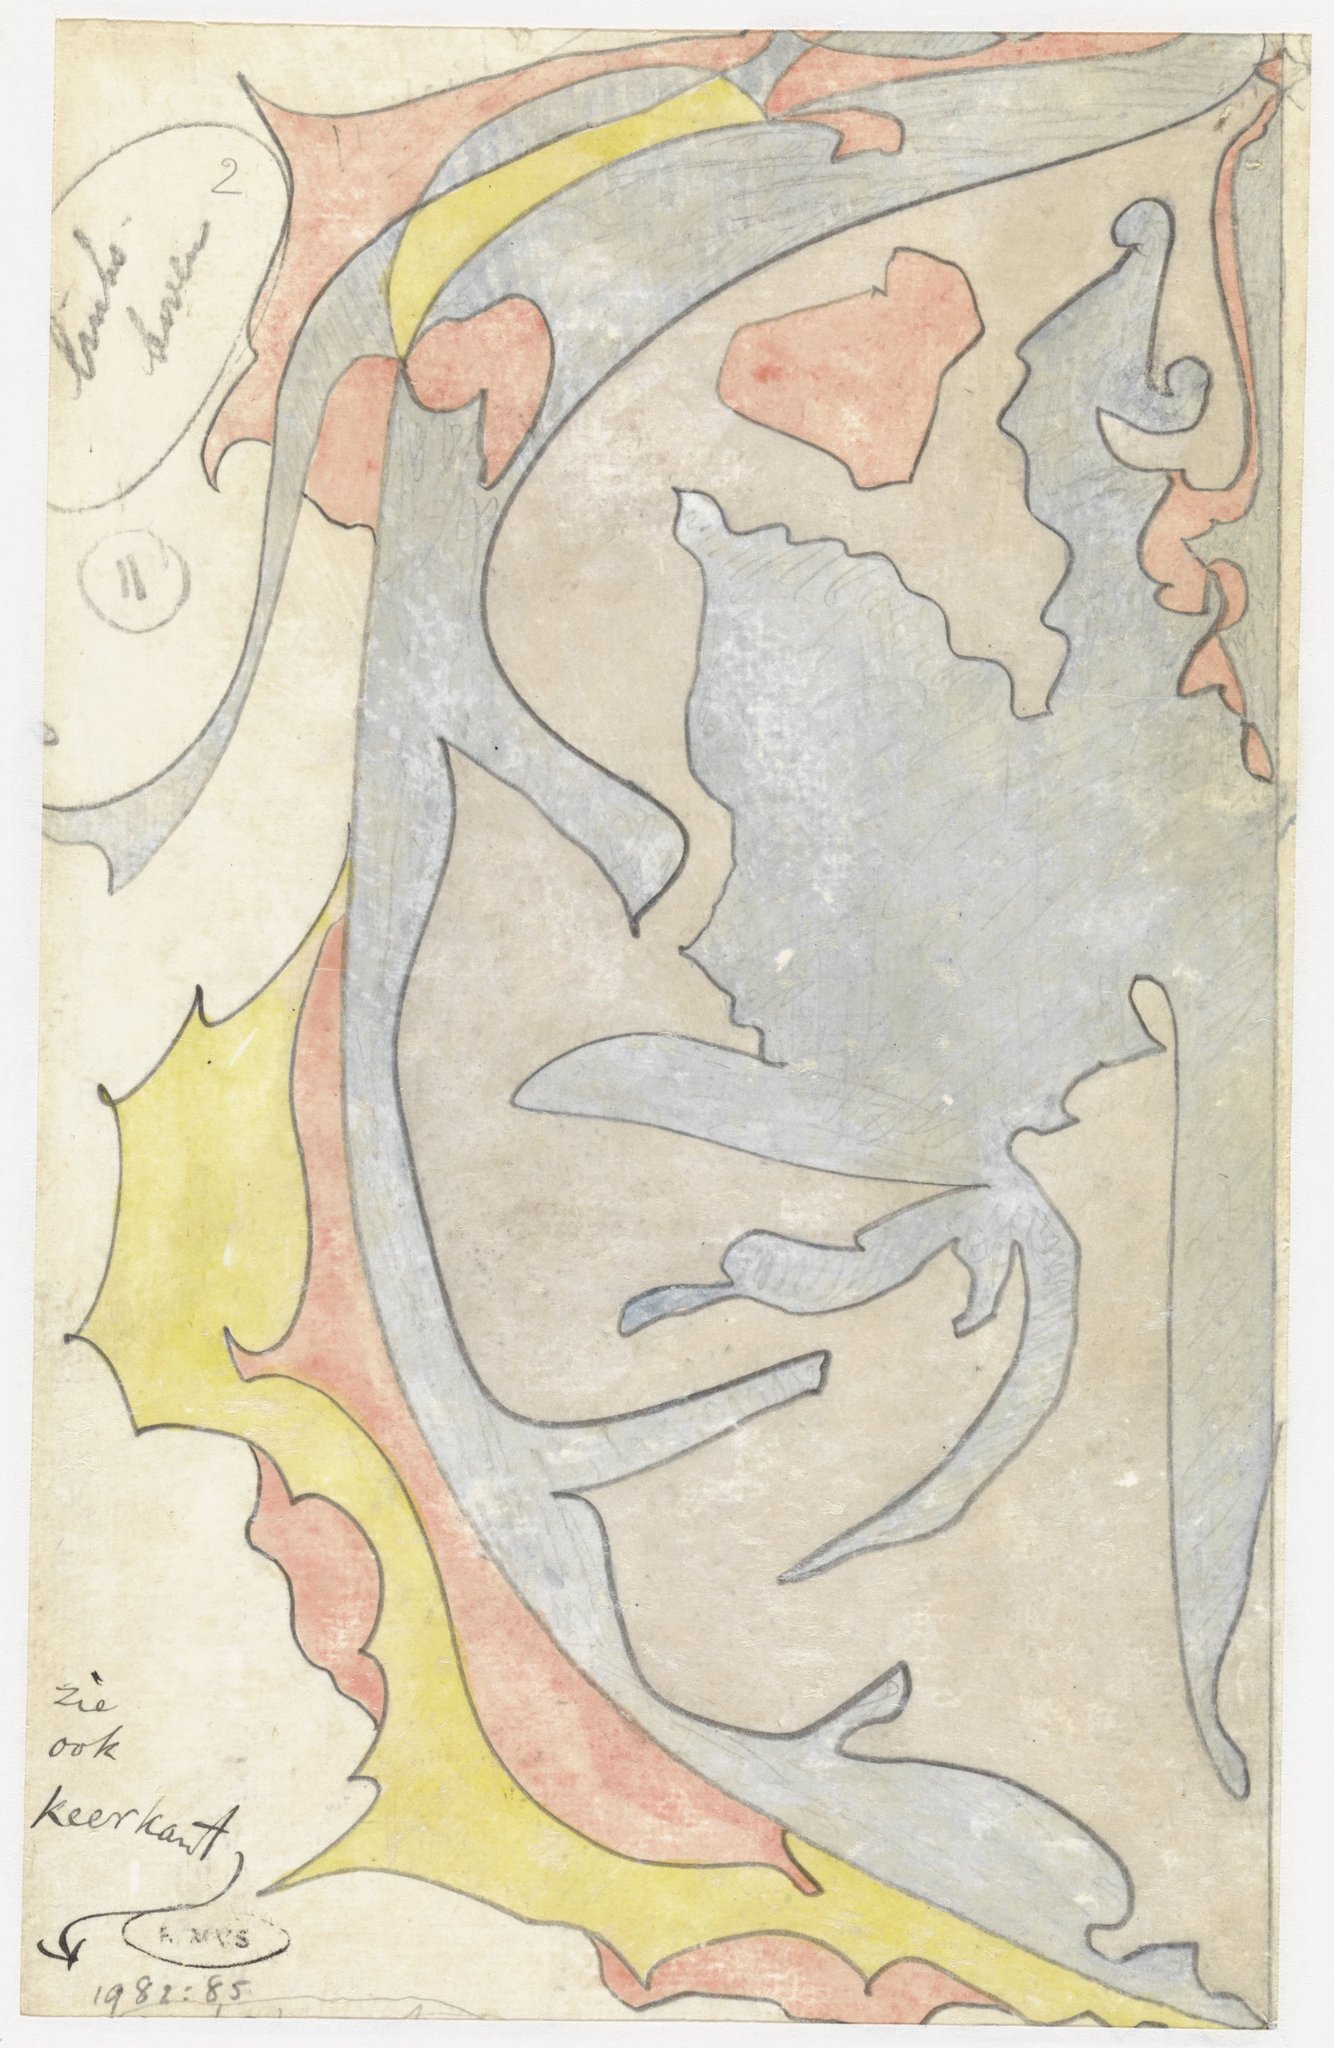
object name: design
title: Floraal ornament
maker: theo colenbrander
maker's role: draughtsman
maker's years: 1841-1930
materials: paper, pencil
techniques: brush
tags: unidentifiable plant forms ~ ornament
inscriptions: date